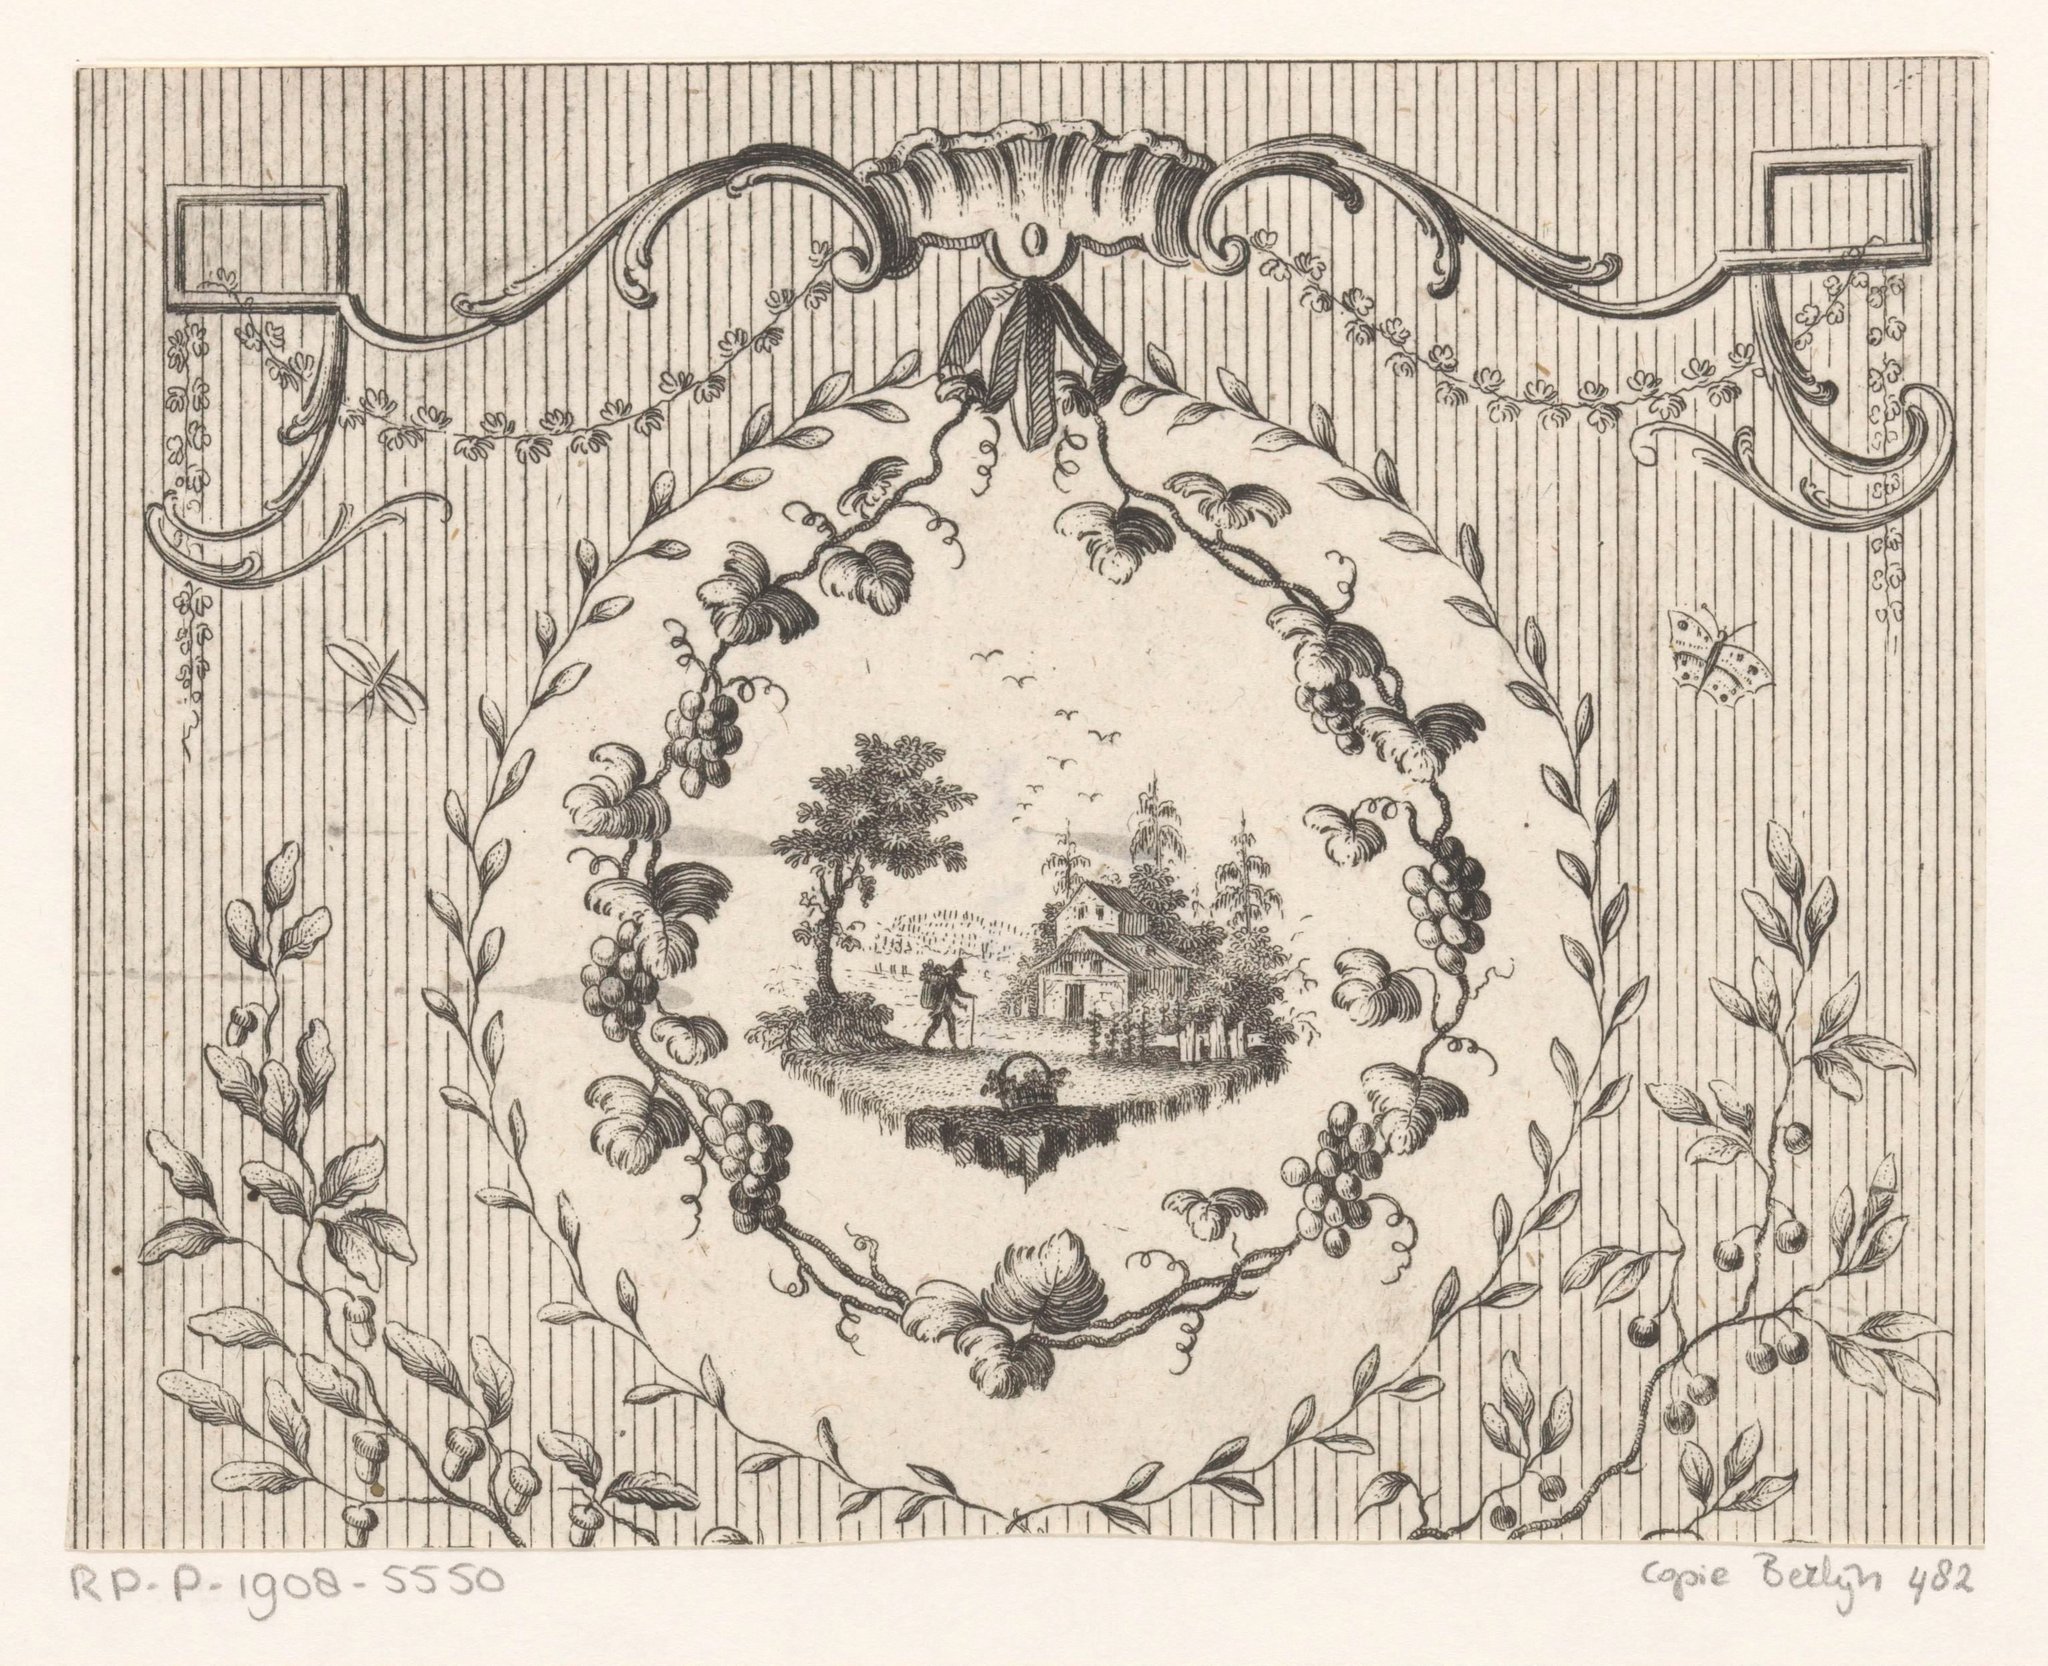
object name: ornament print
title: Medaillon met man met zeis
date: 1746-1775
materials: paper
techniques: etching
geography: augsburg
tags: agricultural implements: scythe, standing figure, ornament ~ medallion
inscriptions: collector's mark: Lugt 2228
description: Een rond medaillon met bloemen, korenaren en een voorstelling van een man met een zeis werkend op het land. Rondom rocaille ornamenten, een dorsvlegel, een hark, een sikkel, rozen, takken met fruit en vogels.